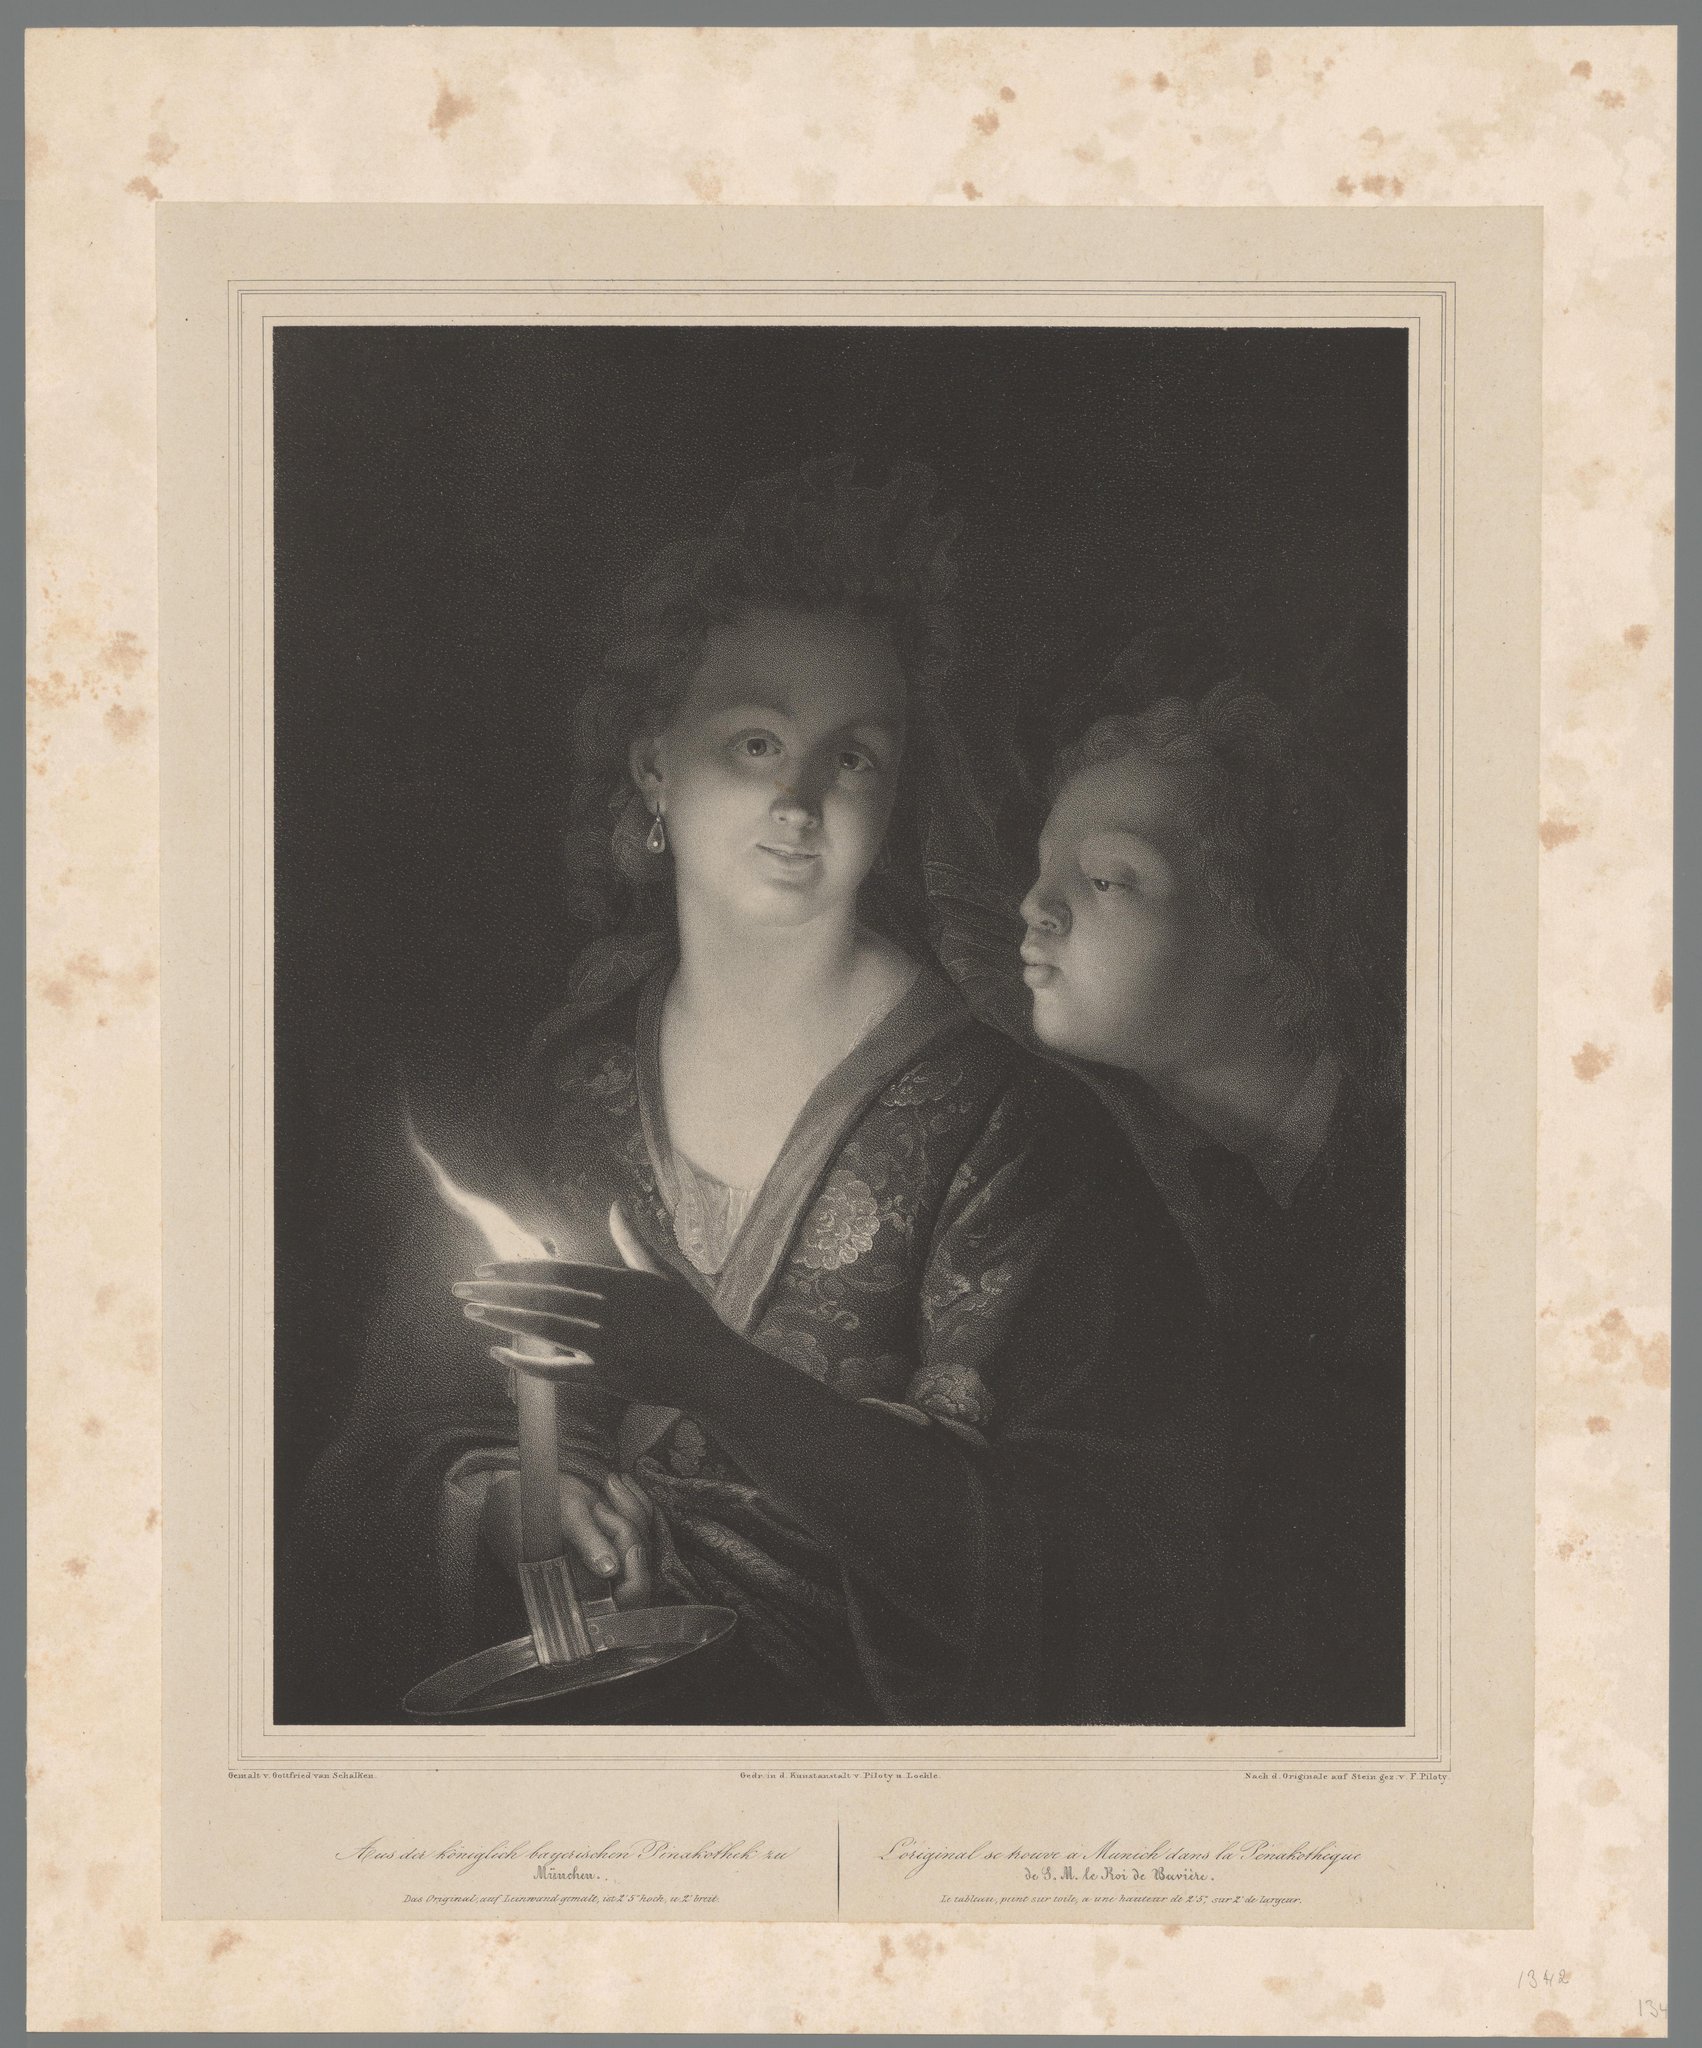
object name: print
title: Twee vrouwen met een kaars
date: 1838-1895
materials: paper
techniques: lithograph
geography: munich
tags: candle, adult woman (+ two persons)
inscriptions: collector's mark: Lugt 2228